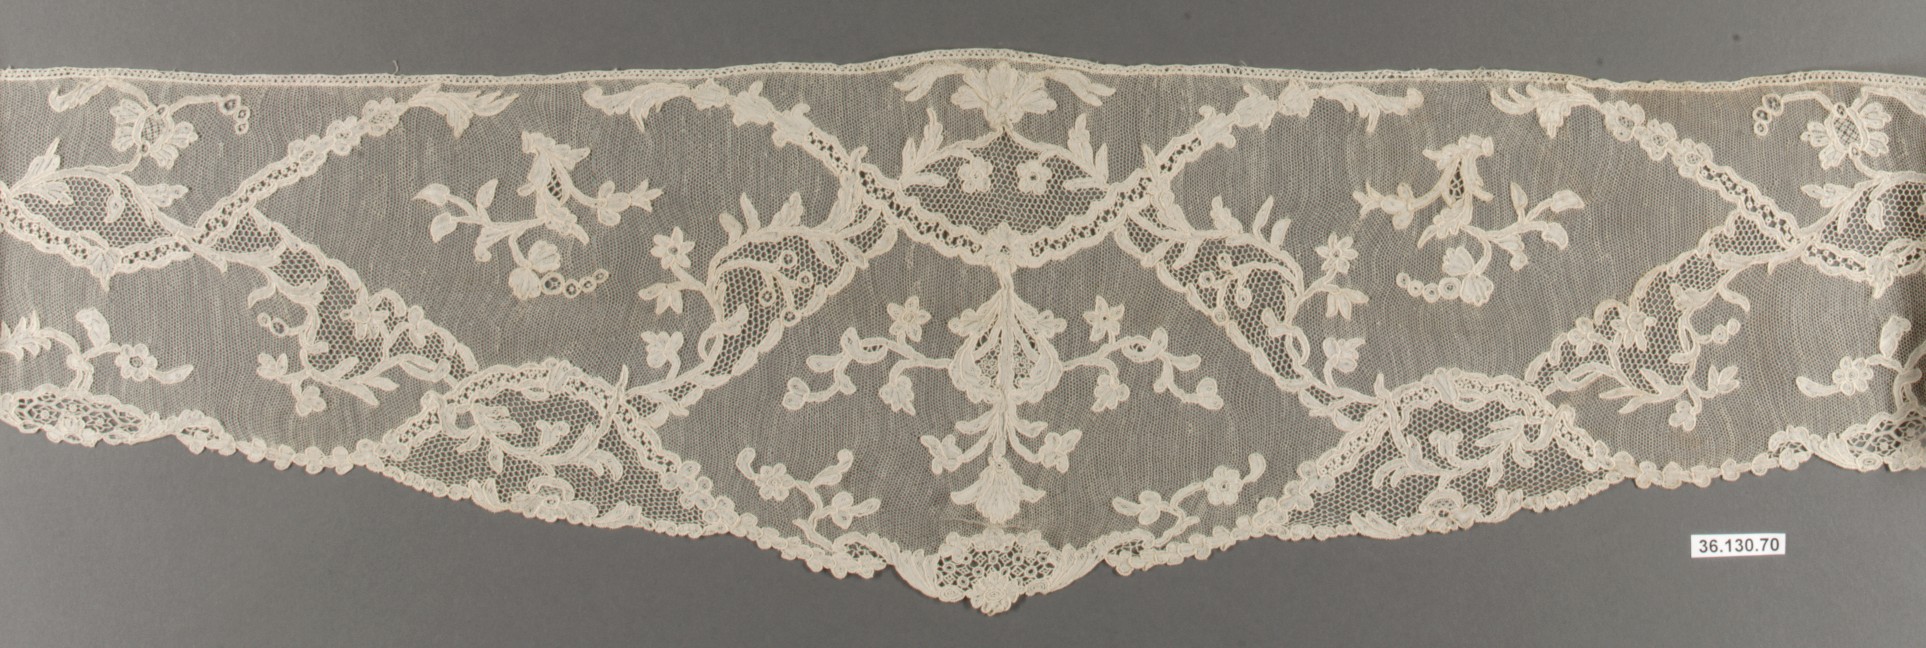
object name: sleeve trimming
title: Sleeve ruffle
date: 1701-1800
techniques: lace